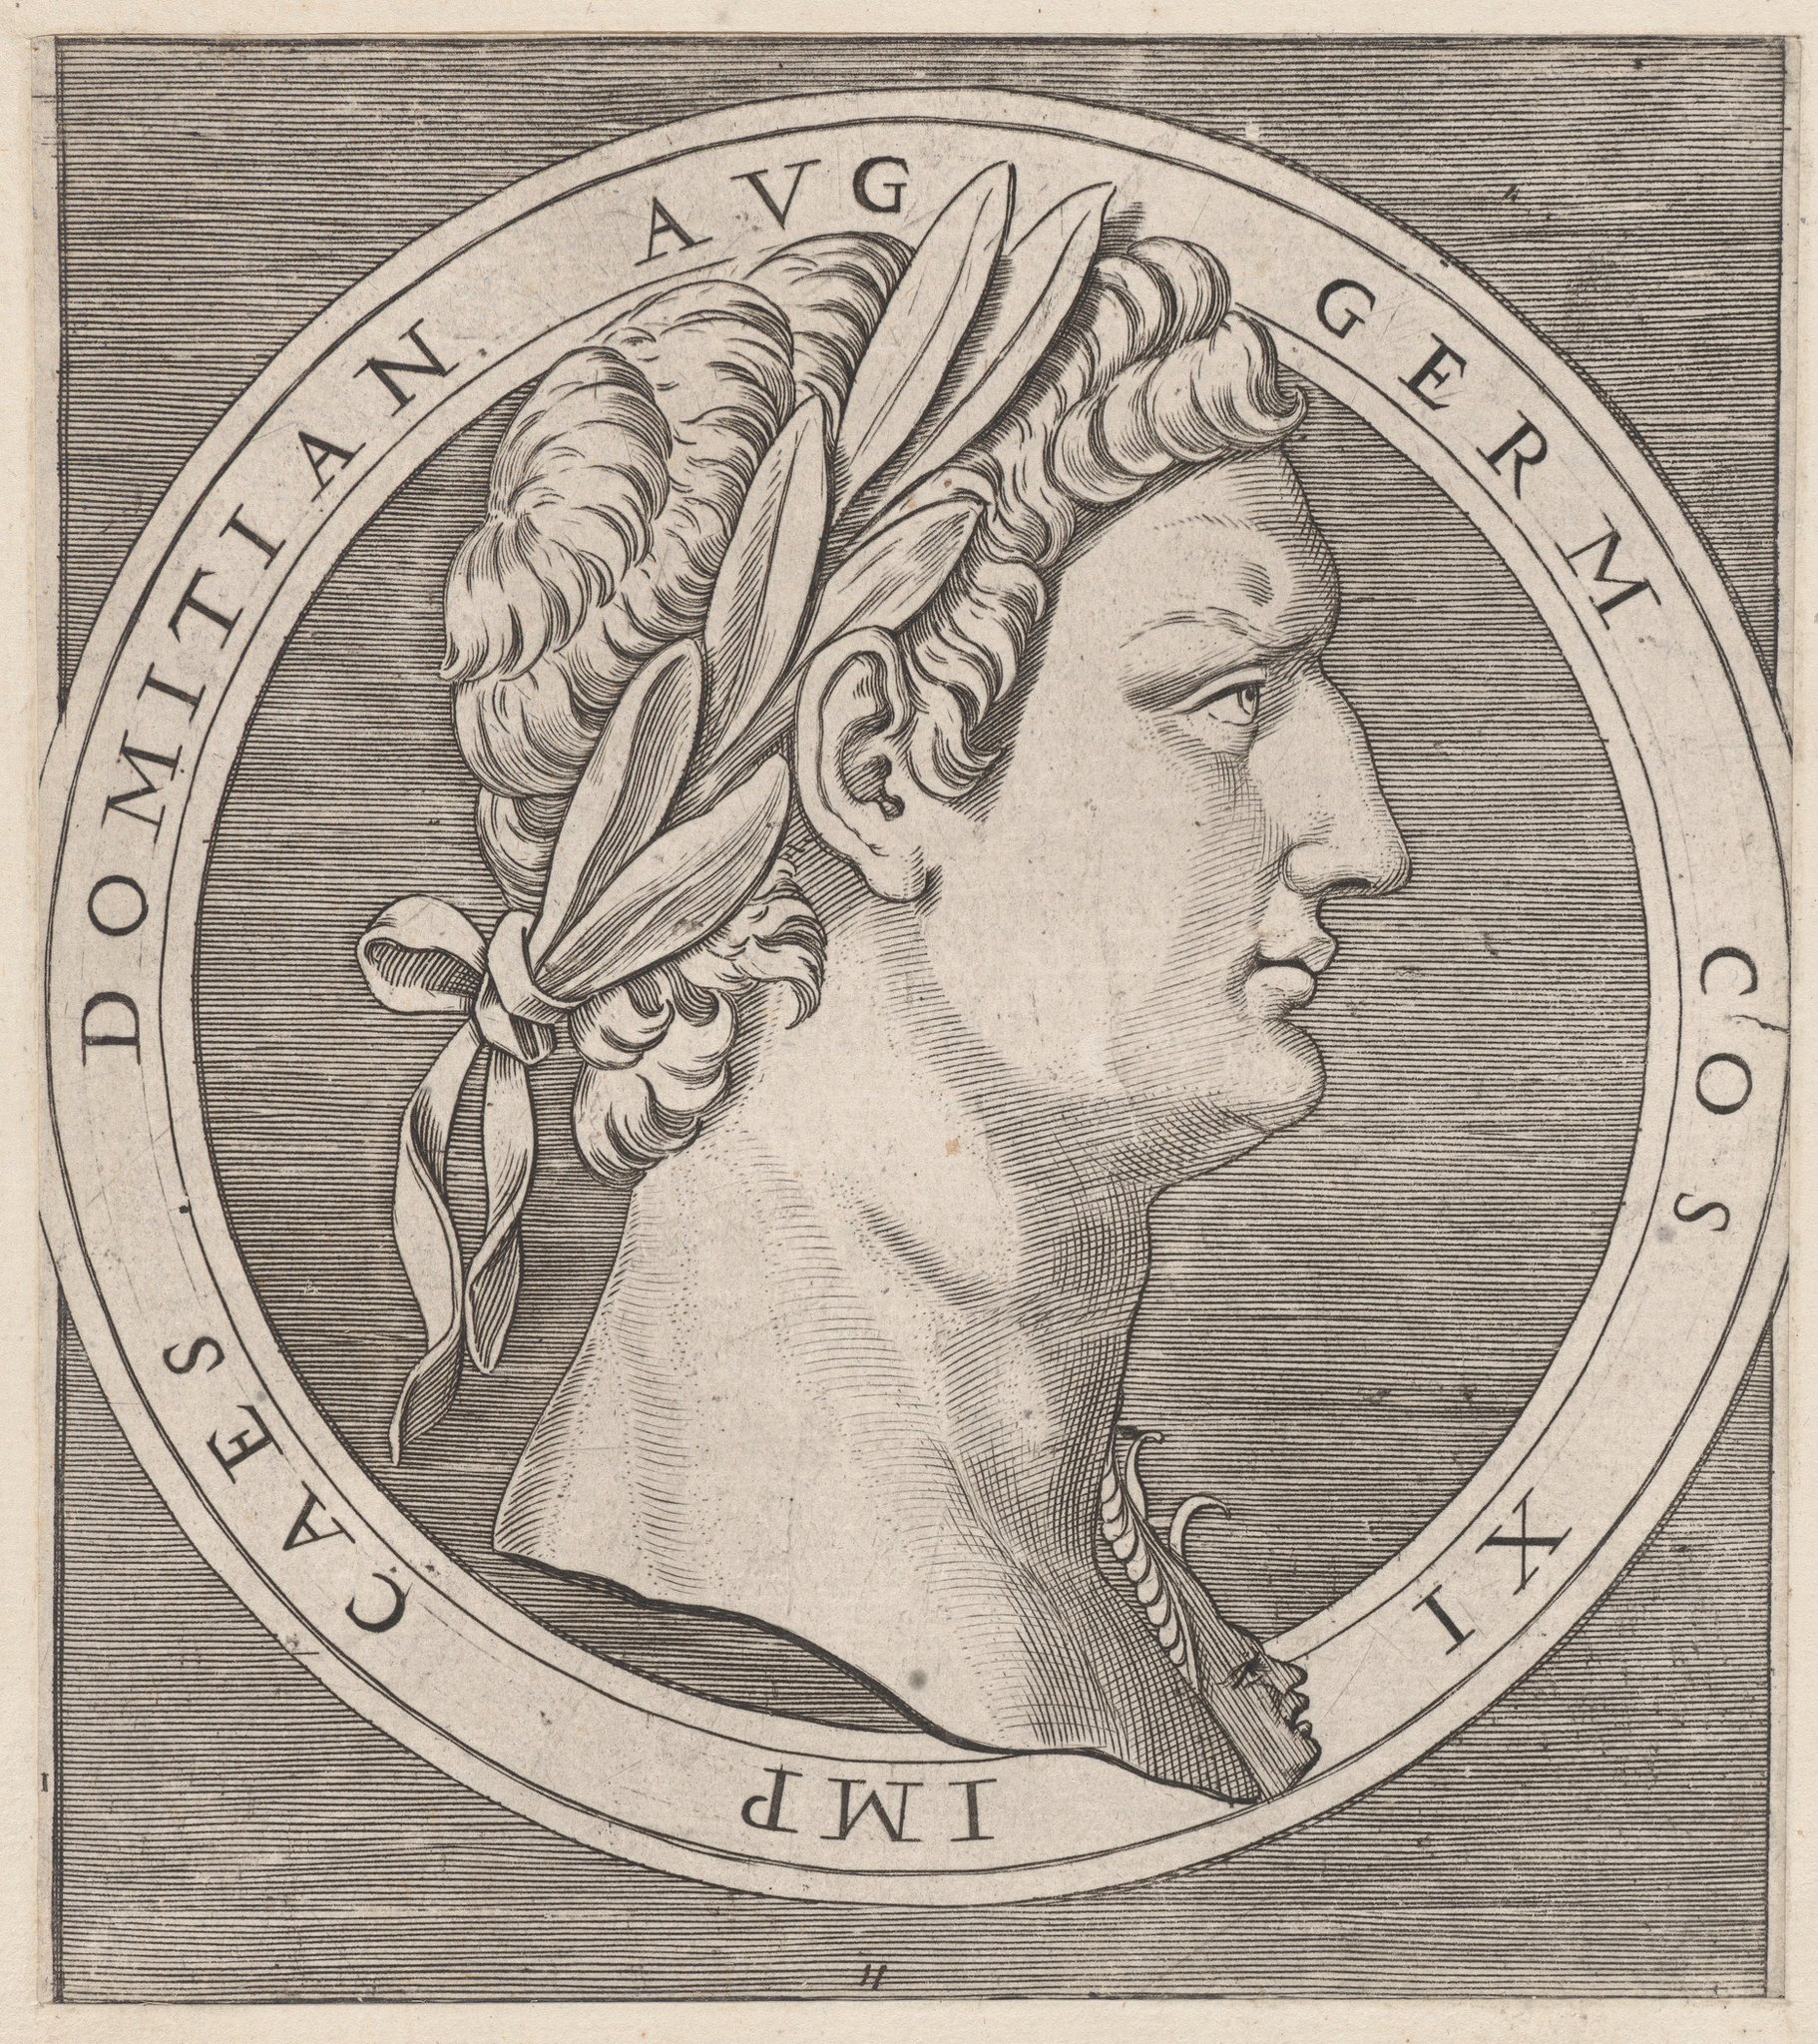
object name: print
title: Domitian, from The Twelve Caesars, from "Speculum Romanae Magnificentiae"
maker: marcantonio raimondi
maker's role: artist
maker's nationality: italian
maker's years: 1475-1534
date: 1500-1534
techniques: engraving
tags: men,profiles